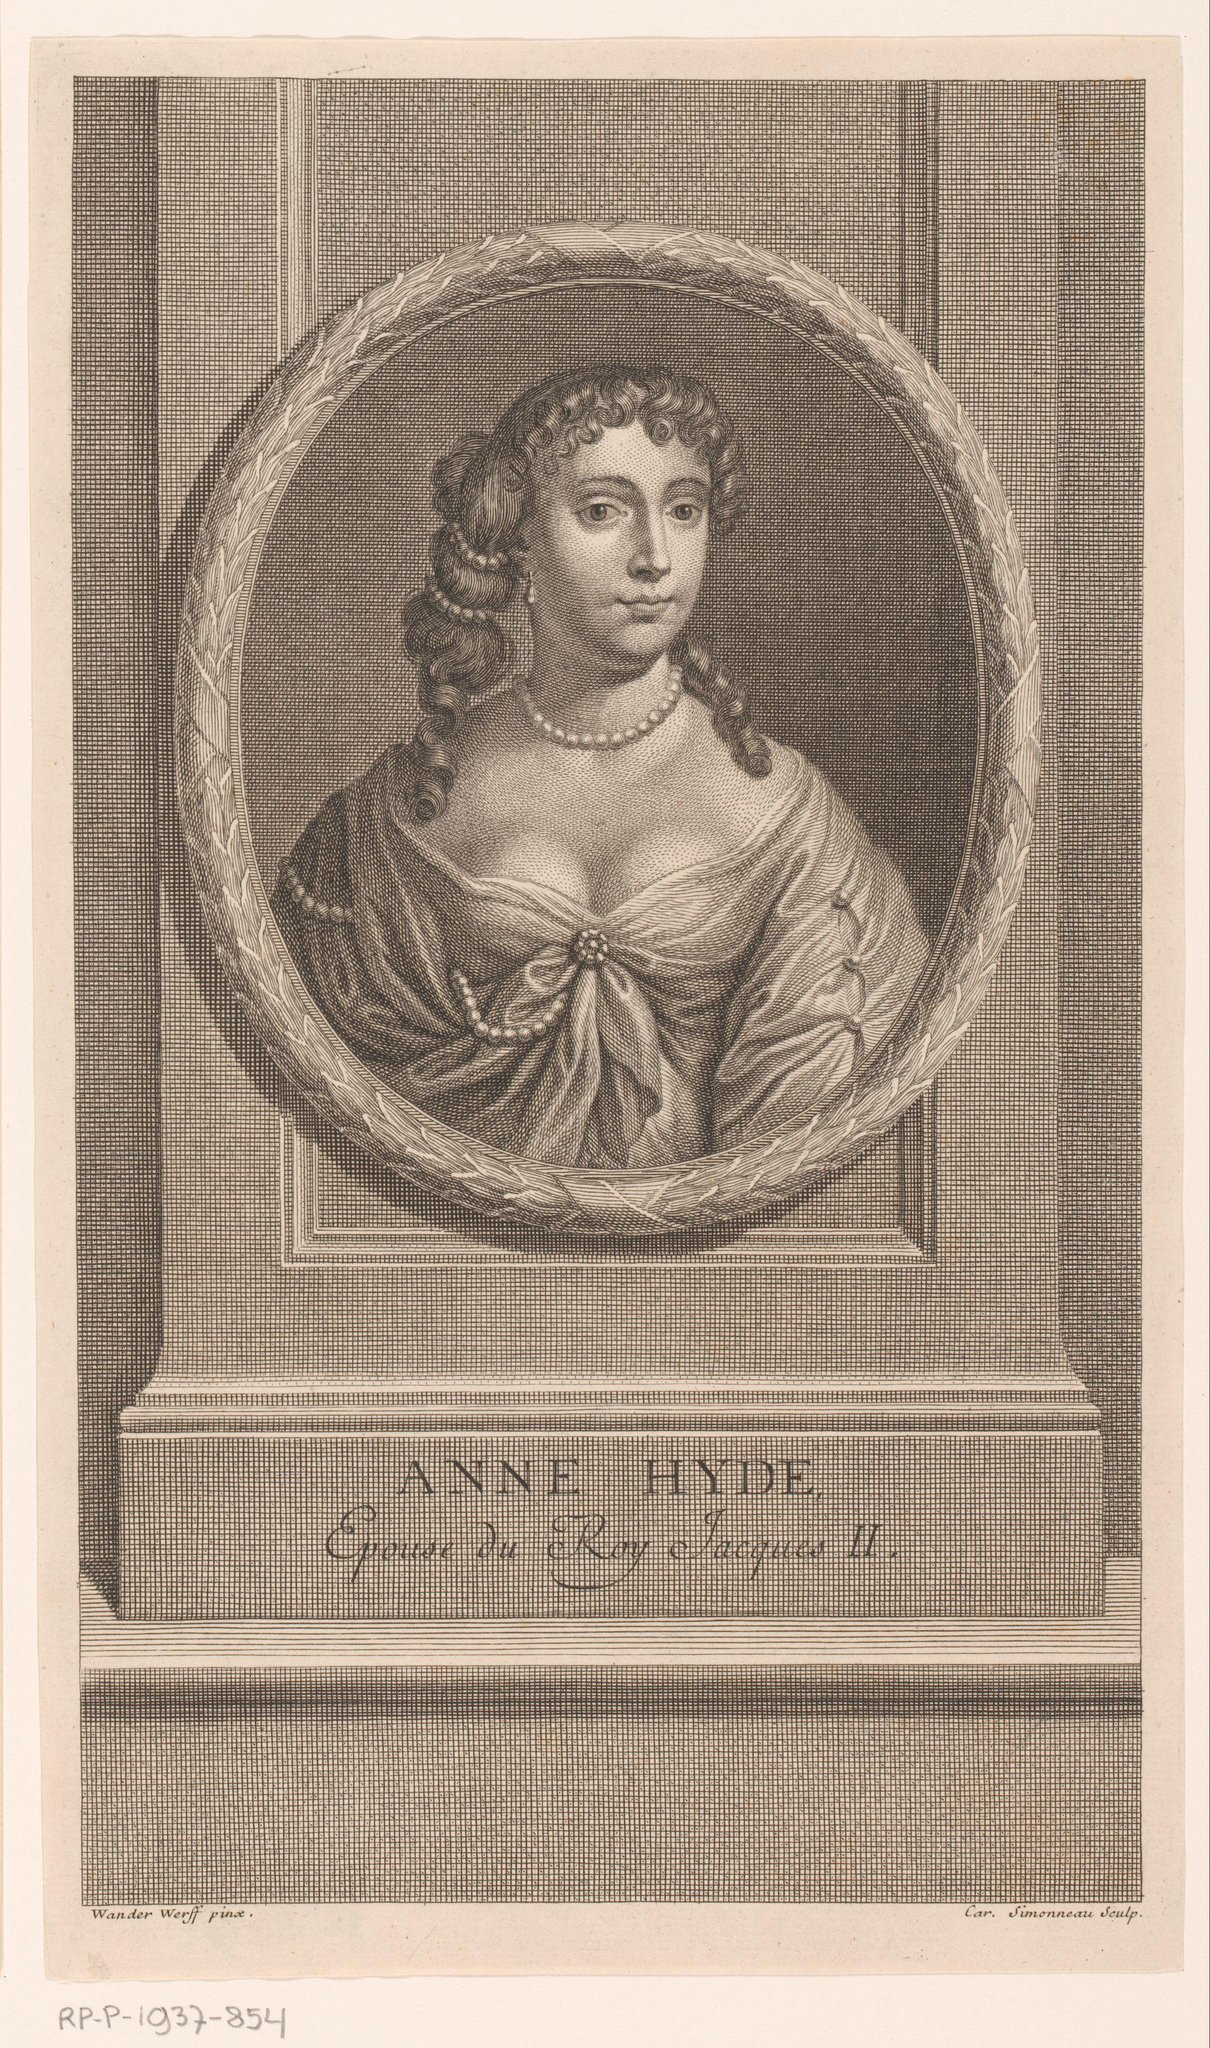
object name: print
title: Portret van Anna Hyde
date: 1655-1728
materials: paper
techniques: engraving, etching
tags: other sovereign (with title) - bb - female ruler, historical persons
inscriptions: collector's mark: Lugt 2228